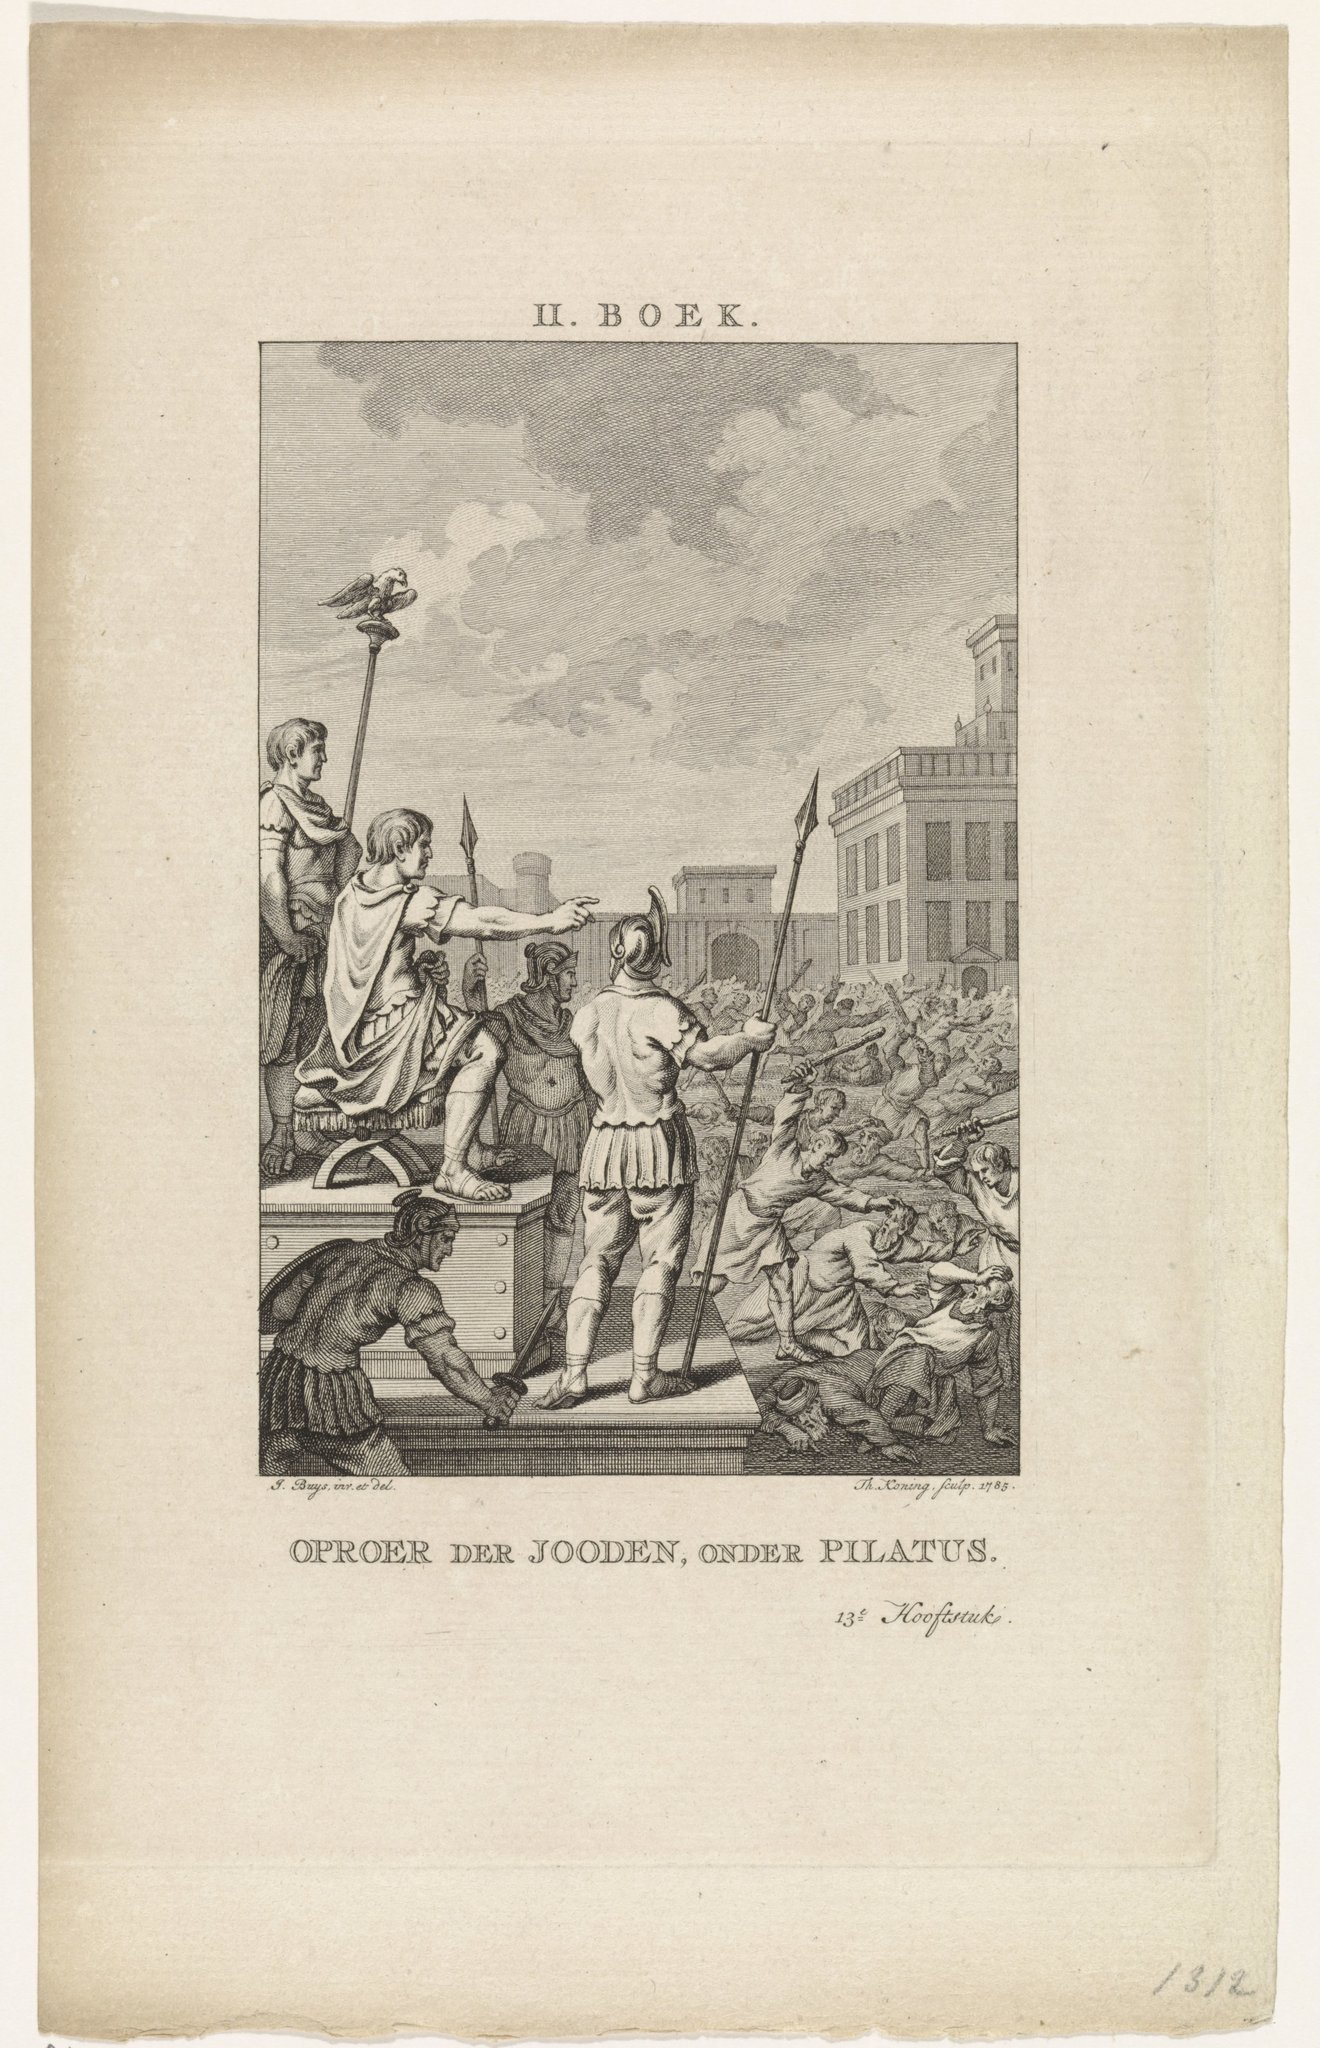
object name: book illustration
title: Opstand van de Joden tegen Pilatus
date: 1785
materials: paper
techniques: engraving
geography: amsterdam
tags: unsuccessful revolution or revolt, suppression of revolutionary activity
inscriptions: collector's mark: Lugt 2228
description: In Caesarea slaan de soldaten van Pontius Pilatus een opstand van de Joden neer, terwijl Pilatus vanaf zijn troon toekijkt. De opstand was ontstaan omdat Pilatus vaandels met afbeeldingen had laten ophangen, waarmee hij één van de Tien Verboden schond. Deze prent is een illustratie bij het dertiende hoofdstuk van het tweede boek van 'Alle de werken van Flavius Josephus'.